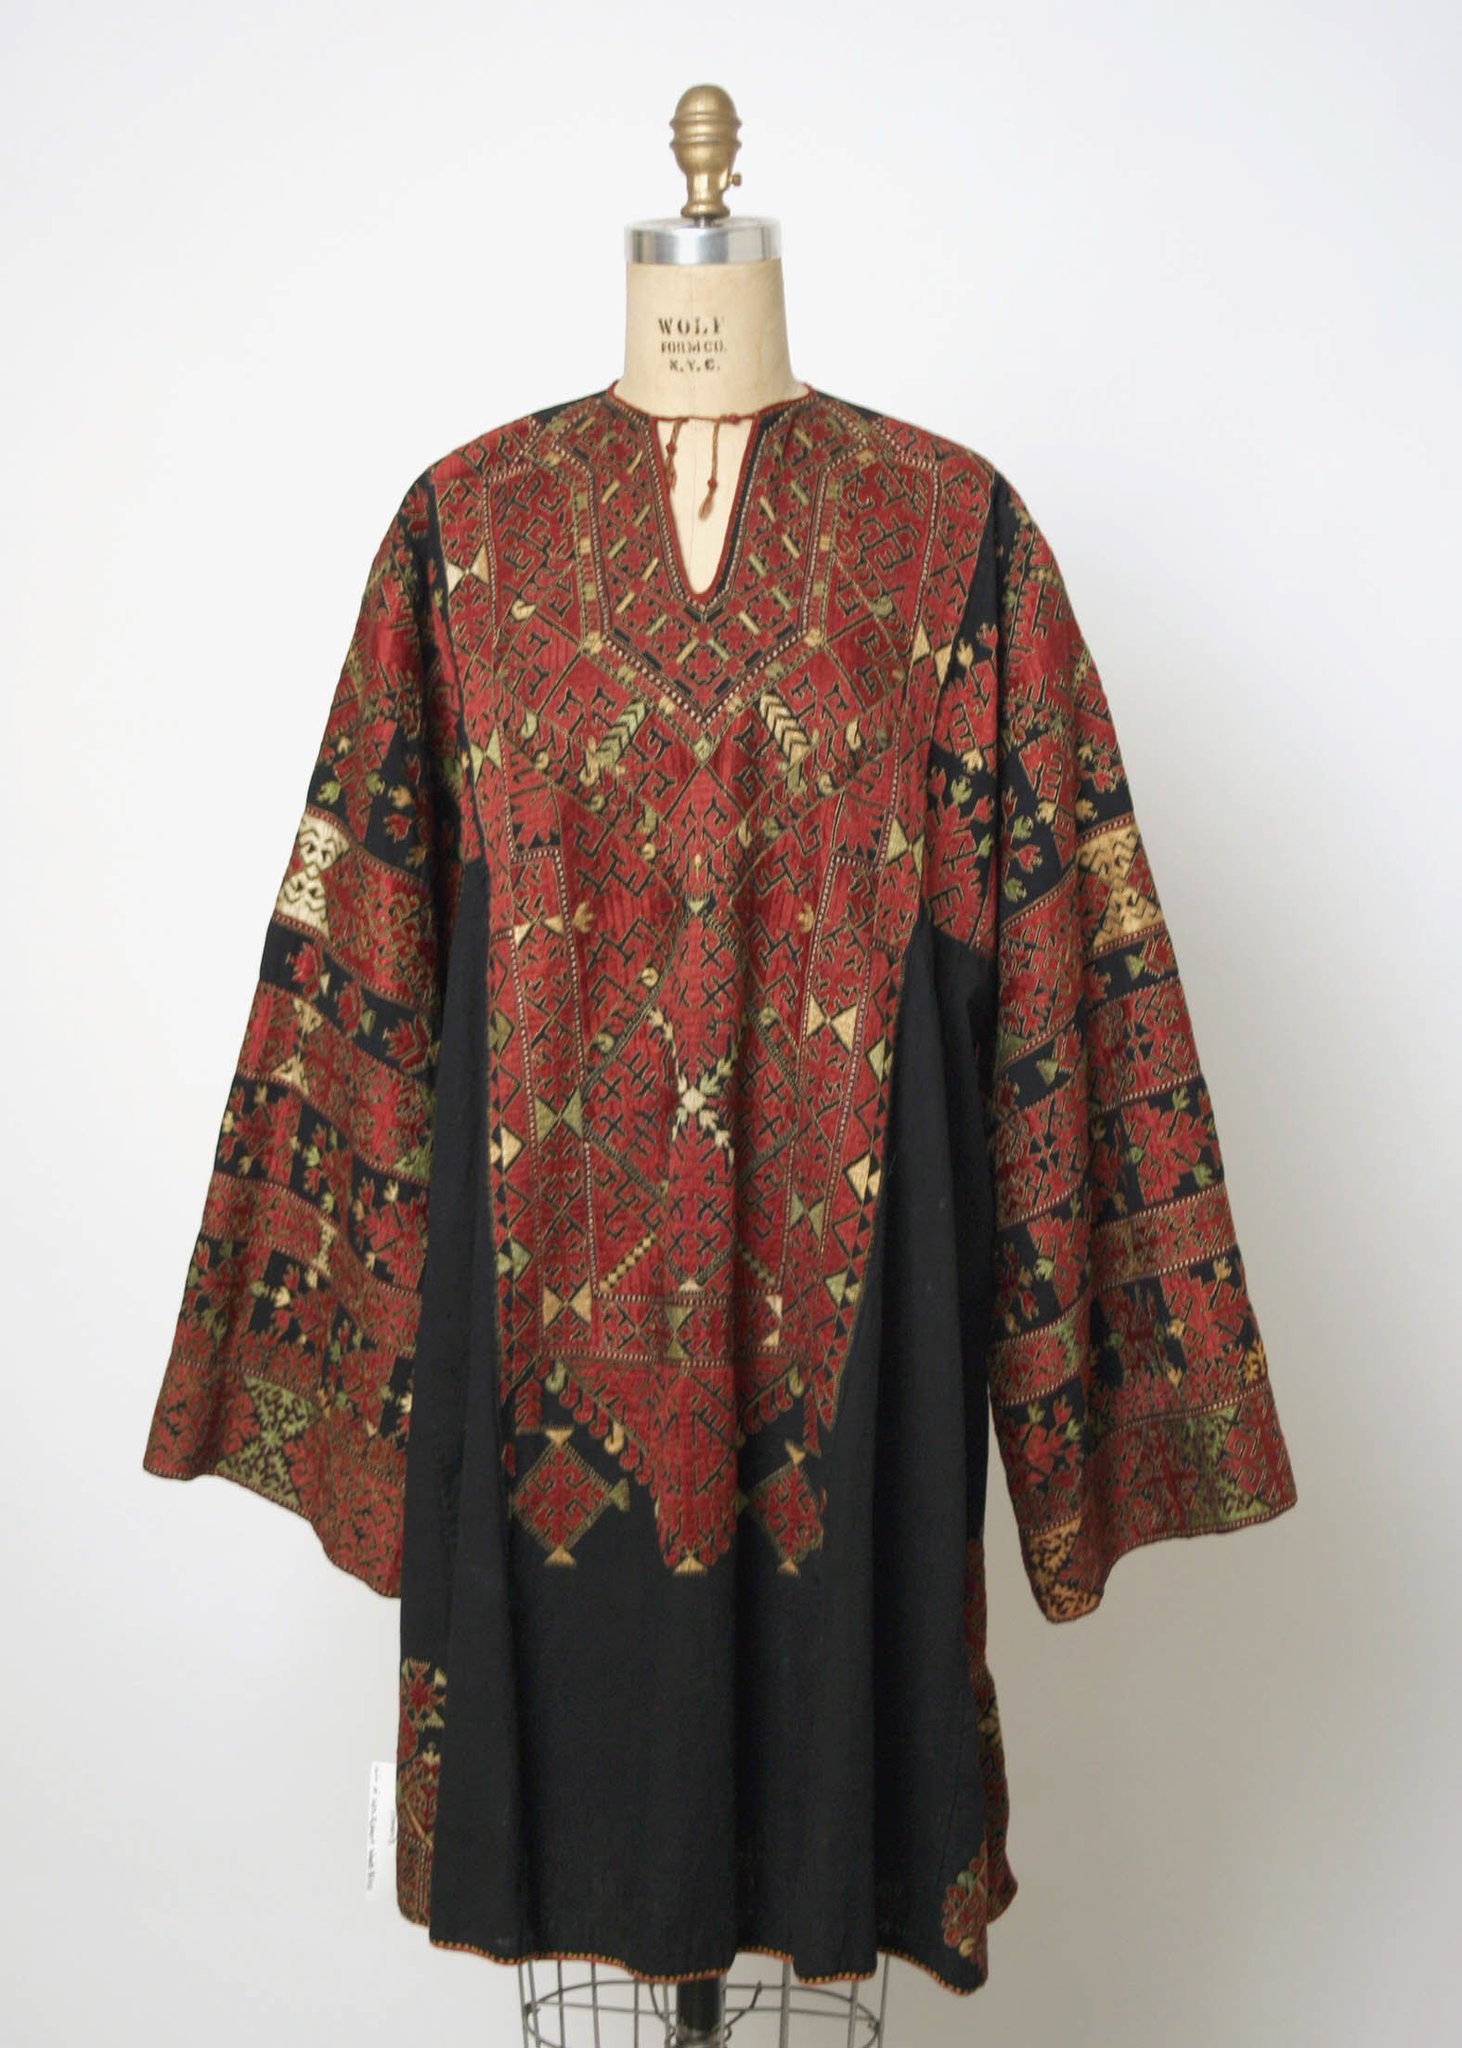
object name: tunic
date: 1867-1900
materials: cotton, silk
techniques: embroidery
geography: pakistan